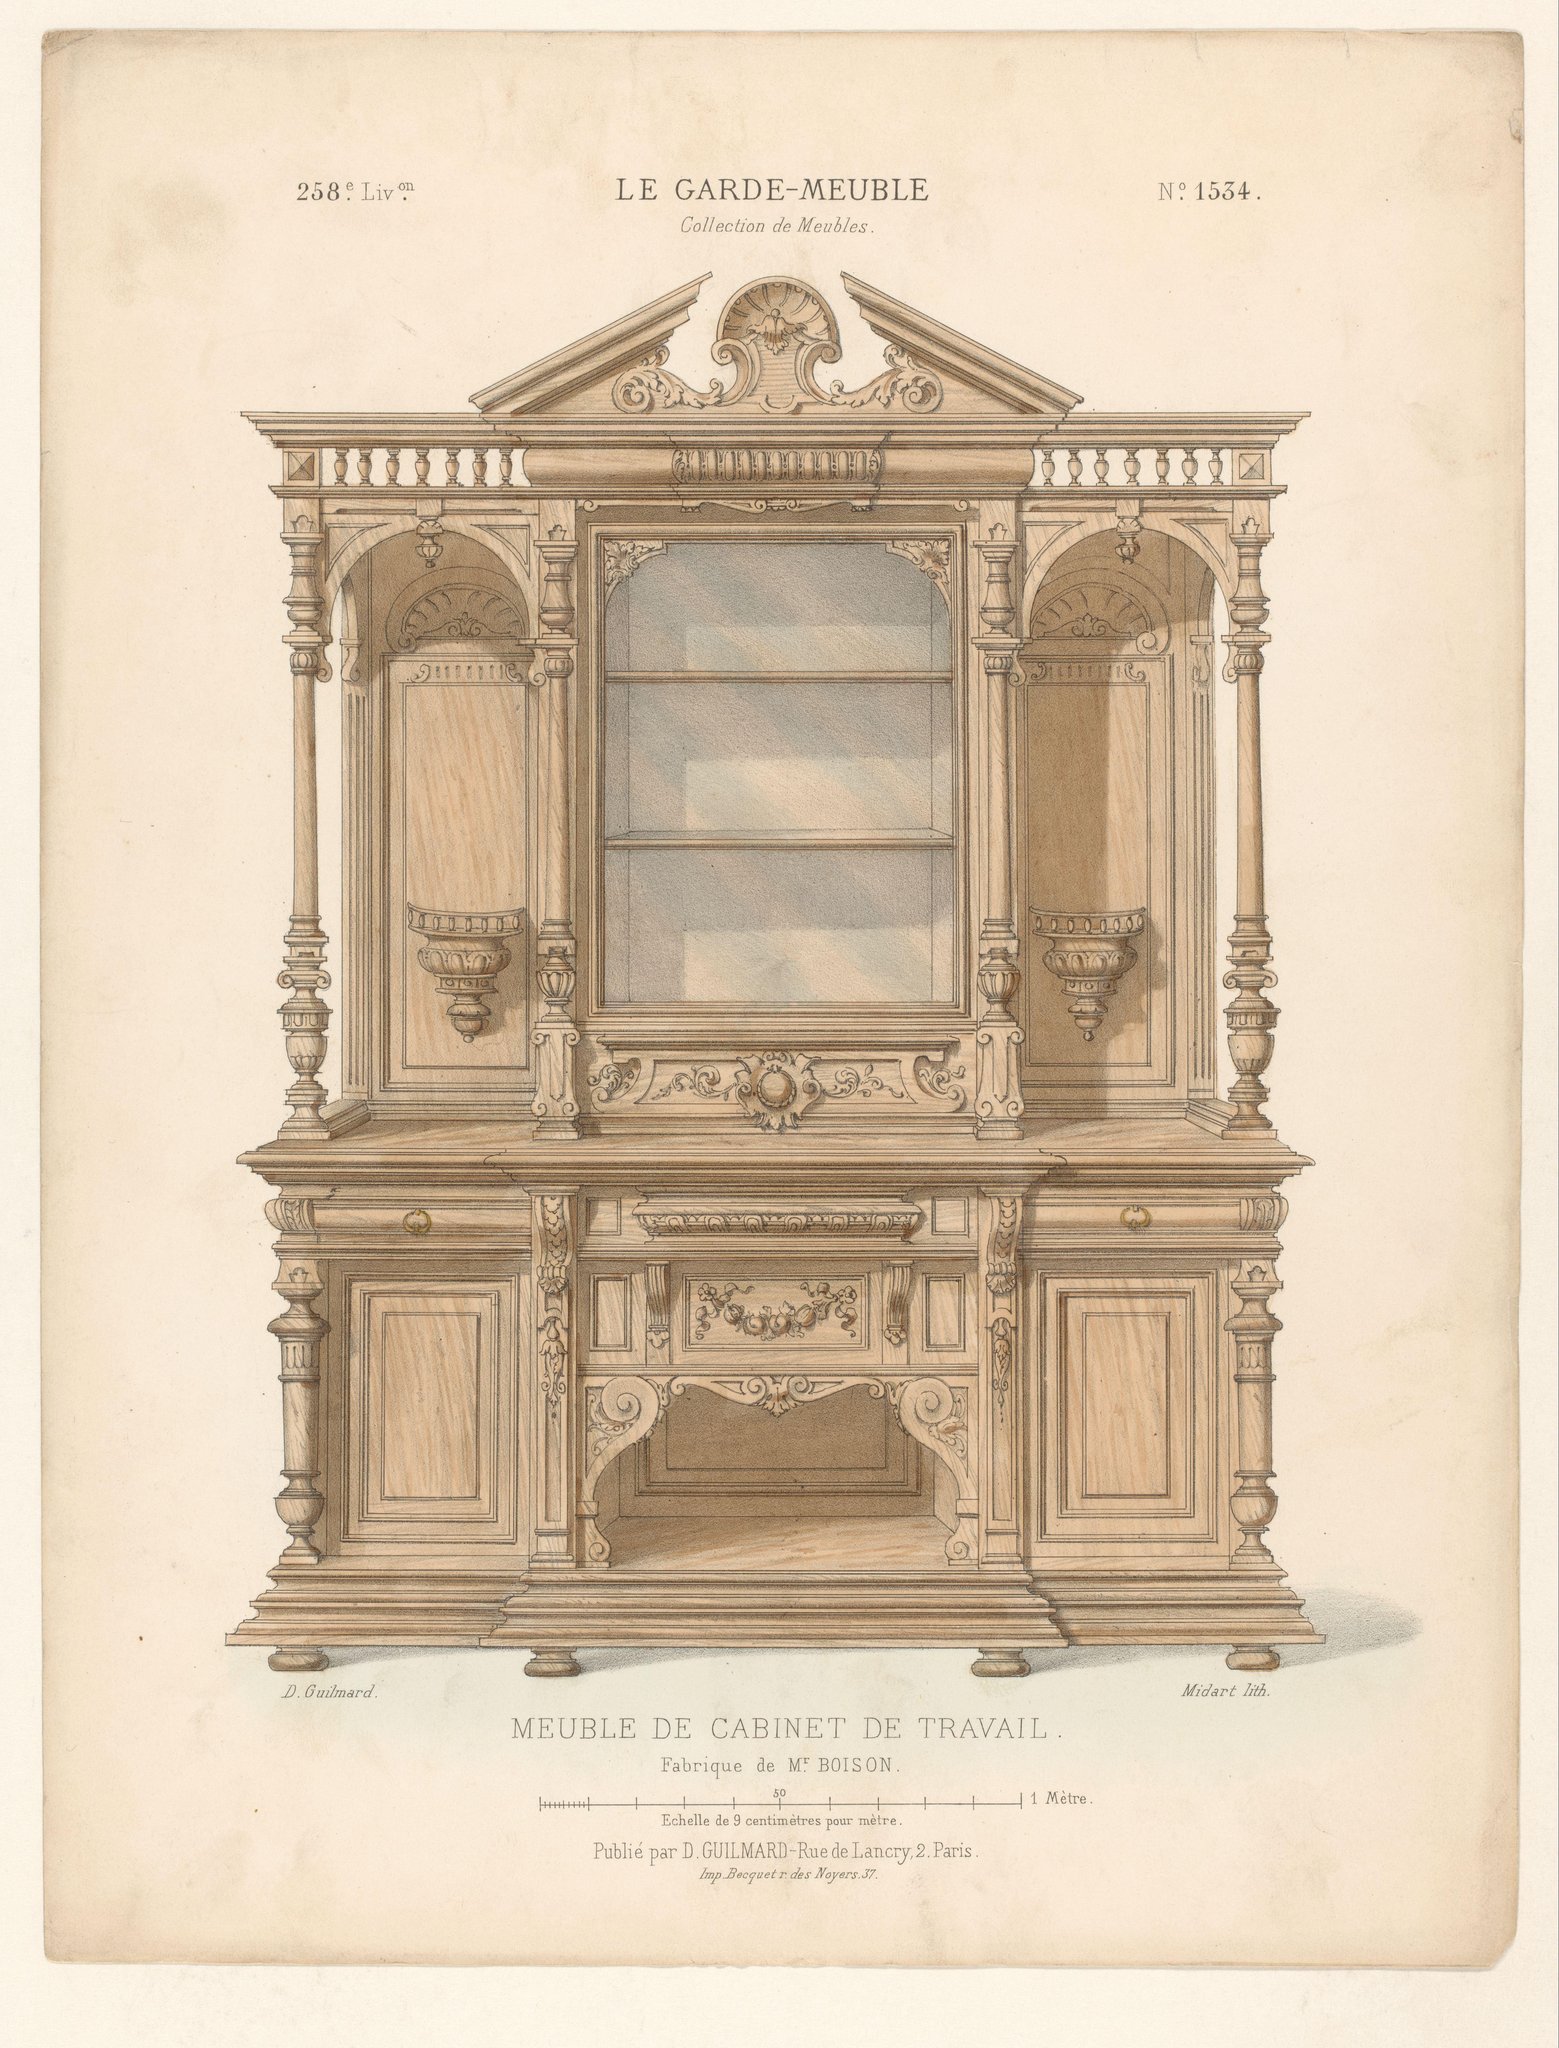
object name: print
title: Kast met nissen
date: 1839-1885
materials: paper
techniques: hand coloring, lithograph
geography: paris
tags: furniture for storage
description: Ieder Livraison in de serie Le Garde-Meuble bevat negen platen: drie 'sièges' (zitmeubels), drie 'meubles' (diverse meubels zoals tafels en kasten) en drie 'tentures' (gordijnen en draperieën).